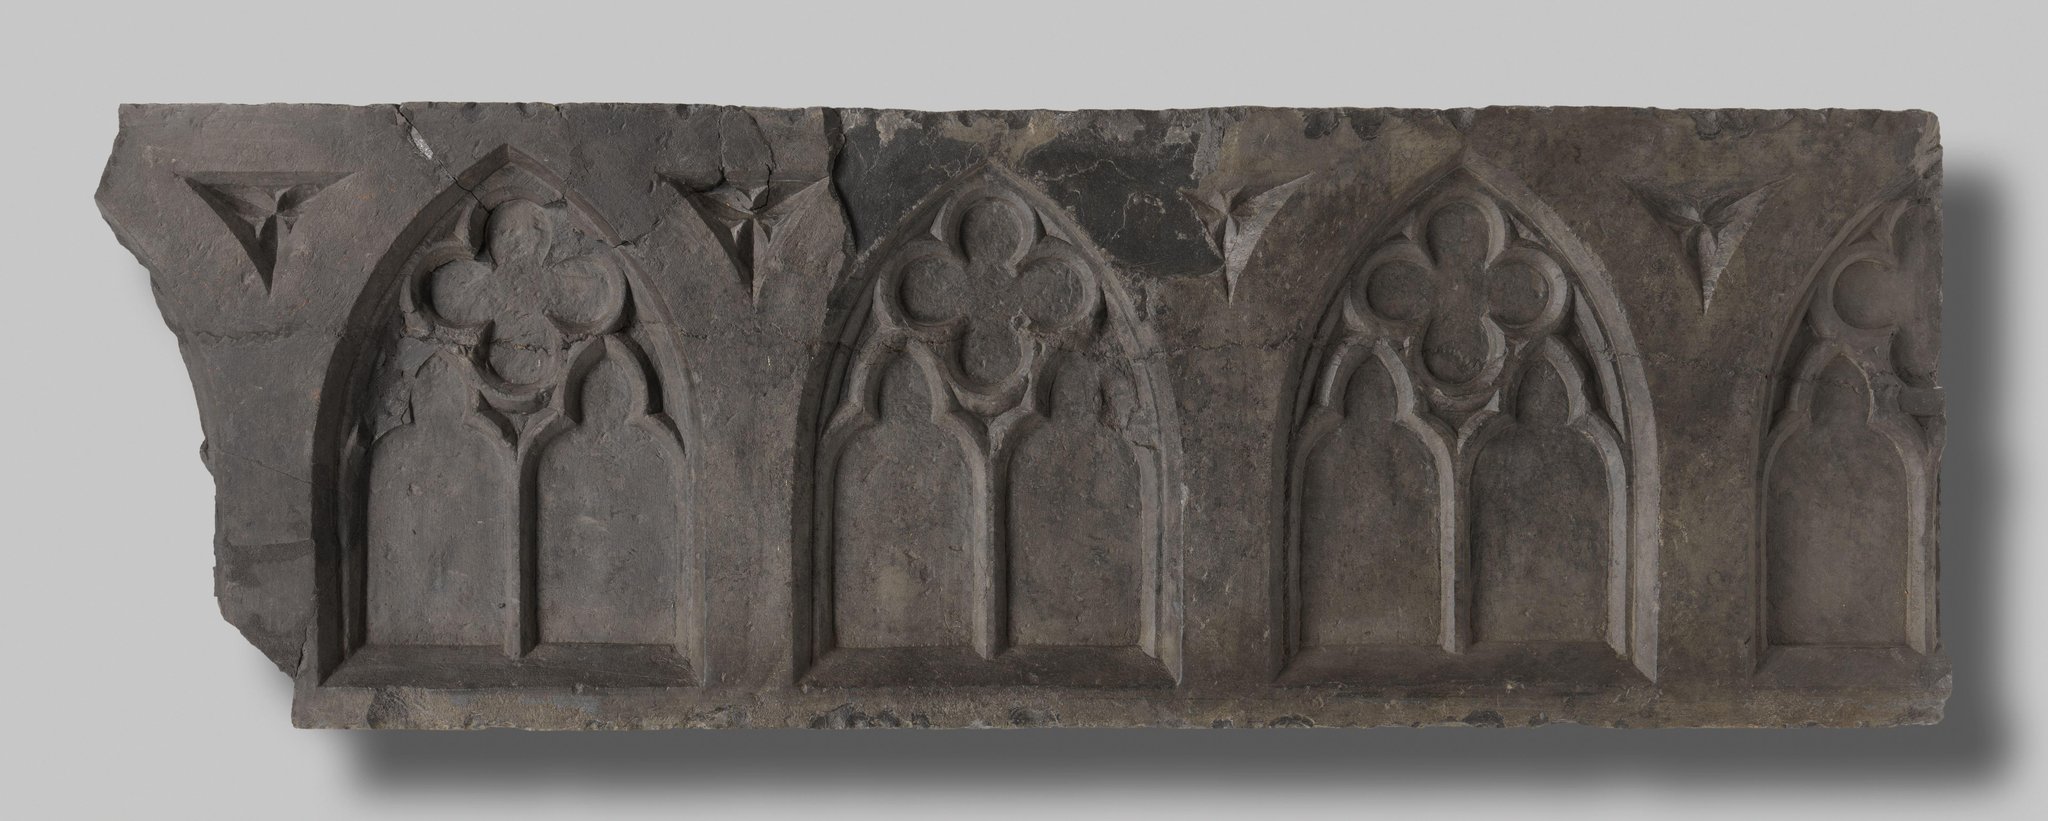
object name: tomb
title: Tomb of Arnold van der Sluis of Heusden, Knight (c. 1245-1296)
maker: Anonymous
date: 1296-1325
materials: limestone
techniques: carved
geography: meuse area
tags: bern (gelderland)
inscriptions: inscription: ‘[Qui fuerat gratus cun]ctis iac[et] h[ic] tumulat[us] Husde[n]si nat[us] ex clara stirpe vocat[us] Arnold[us] mile[s] de slusa sp[er]ne[re] viles Act[us] h[ic] novit falso[s] [a] seque removit Fortis formosus prudens erat atque animosus Justus pacifuc probitati semper amicus Finiit is vitam morum gravitate p]olita[m] Q[ua]rto redde[n]das a mense dec[em]bre kale[n]das. An[n]o milleno d[omi]ni noviesq[ue] noveno Et bis centeno terno quo[que] cu[m] duedeno Gaudeat in c[oelis ut hoc orat] quis[que] fidelis Hoc pater et flamen sacrum nat[us]q[ue] [det amen]’, coat of arms, coat of arms, in relief, coat of arms, in reliëf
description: Onderdeel van de graftombe van Ridder Arnold van der Sluis van Heusden. In het onderdeel staan vier gotische bogen en een halve boog.